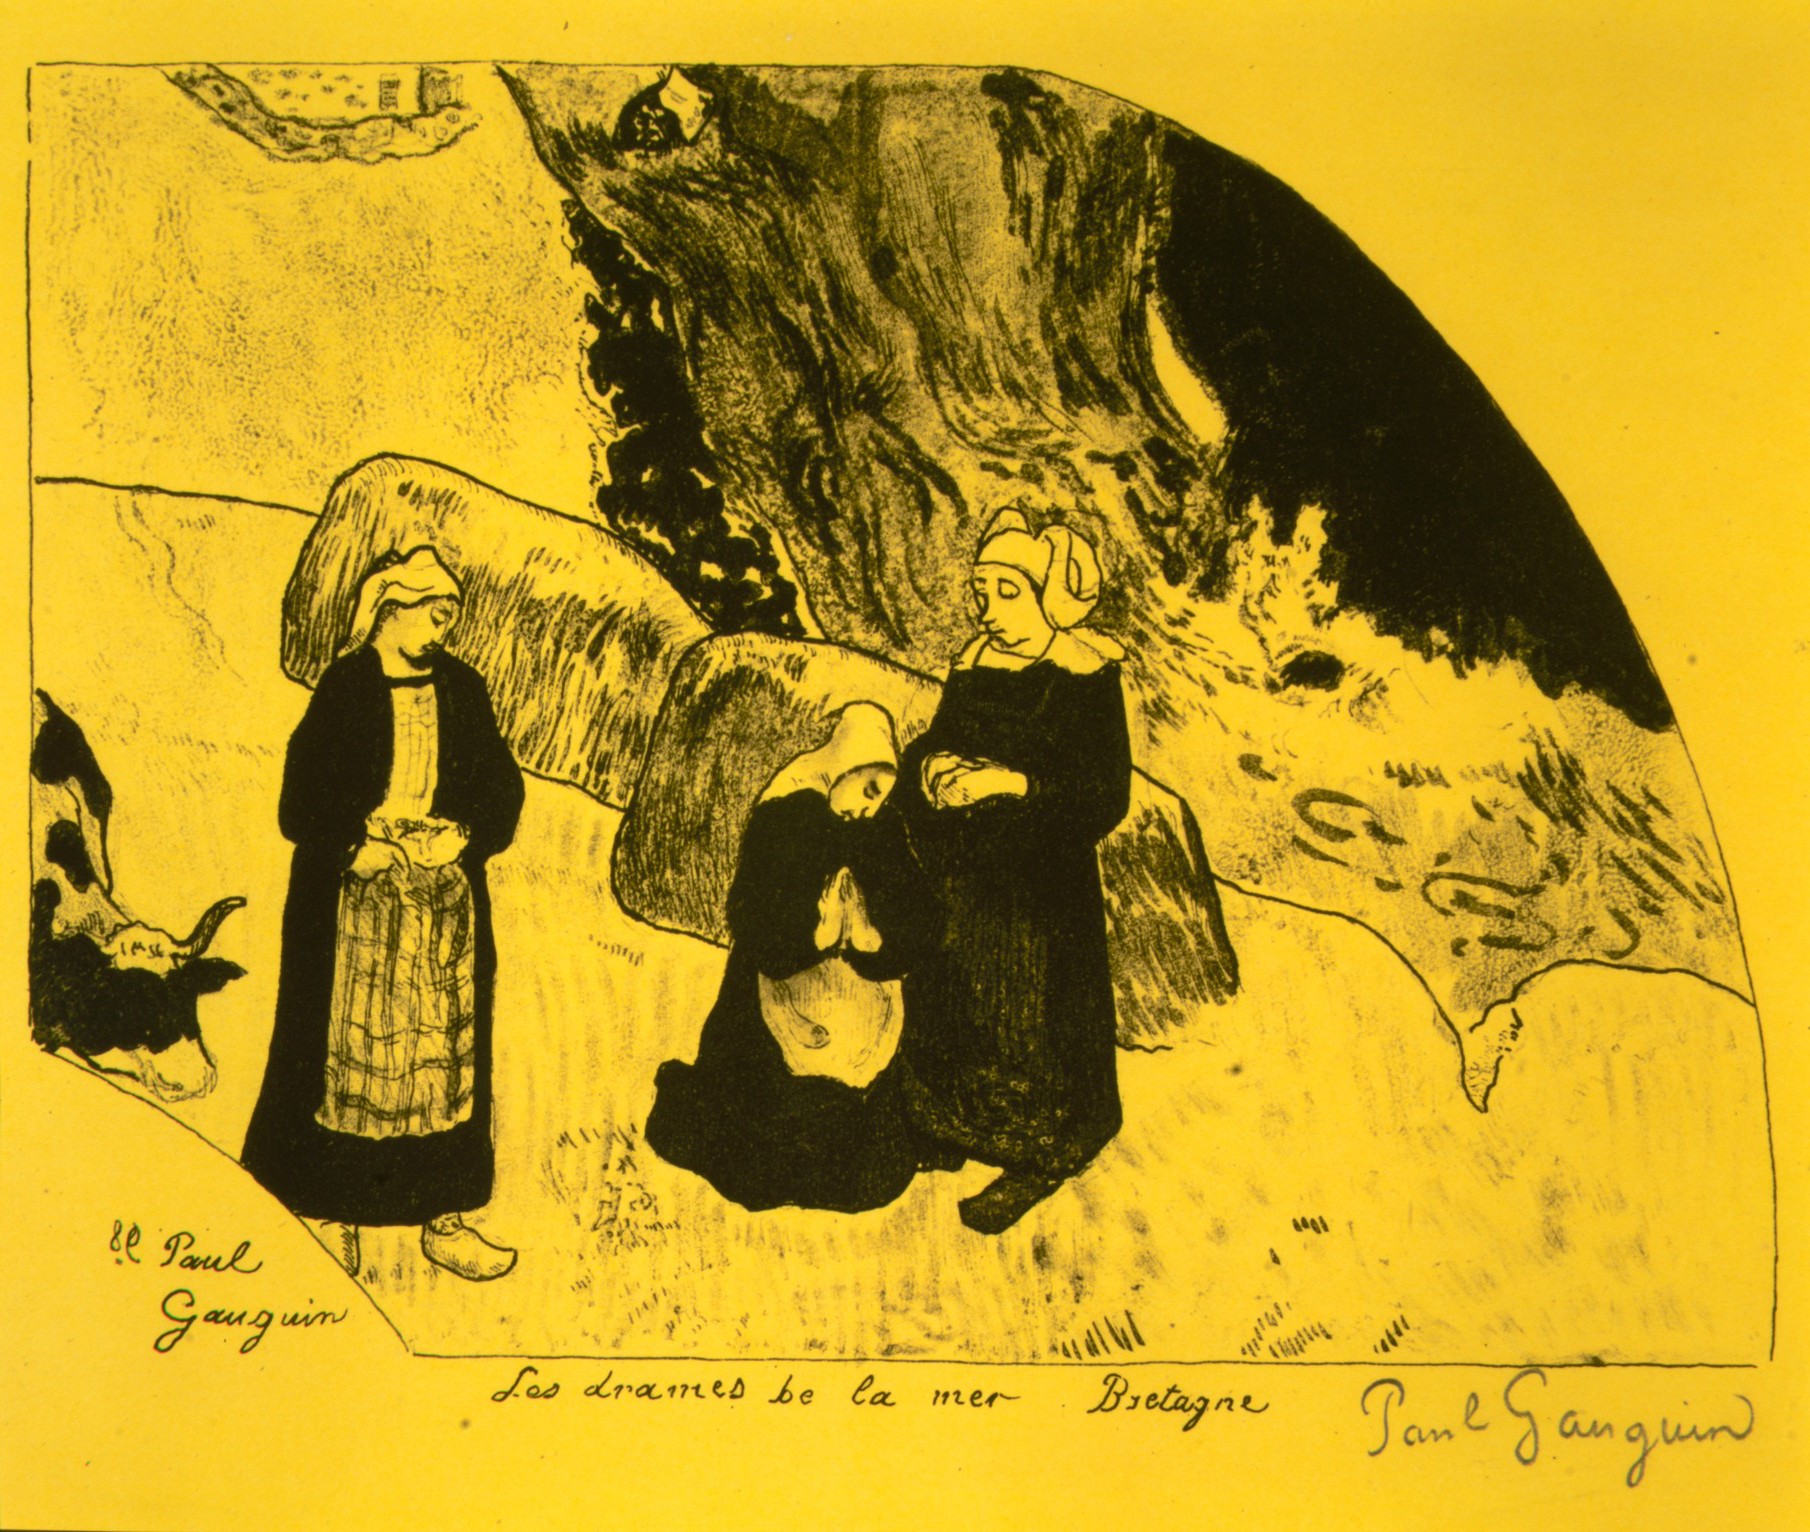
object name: print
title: The Drama of the Sea, Brittany, from the "Volpini Suite: Dessins lithographiques"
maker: paul gauguin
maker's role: artist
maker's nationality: french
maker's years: 1848-1903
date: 1889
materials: paper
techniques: lithography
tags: women